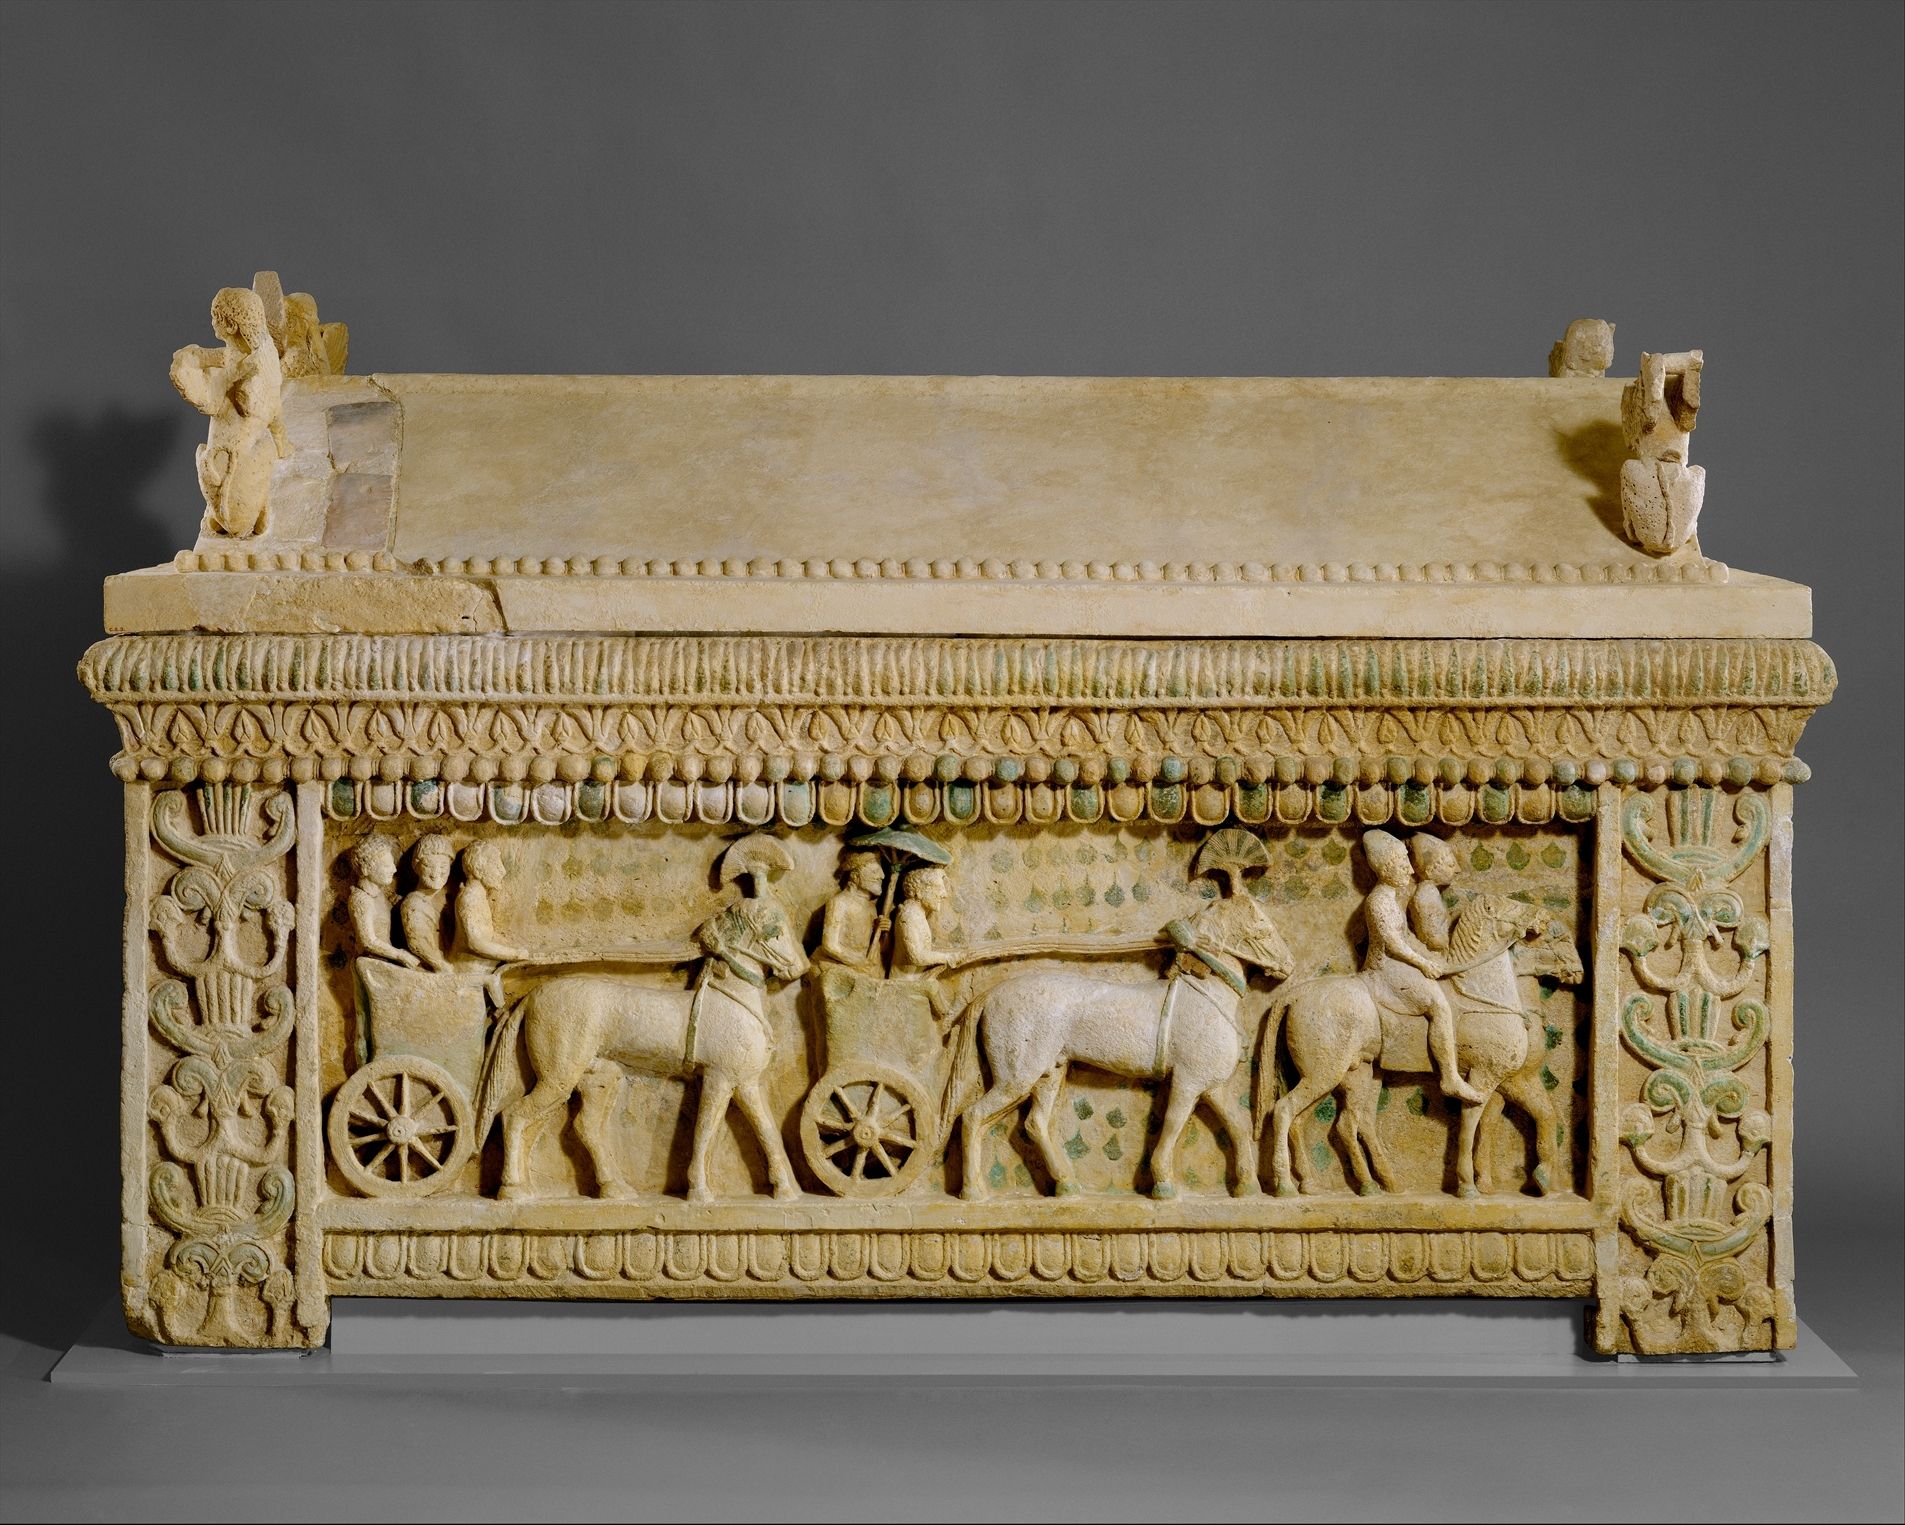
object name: sarcophagus, amathus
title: Limestone sarcophagus: the Amathus sarcophagus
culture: cypriot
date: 475-451 BCE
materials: limestone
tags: men,female nudes,sphinx,horses,chariots